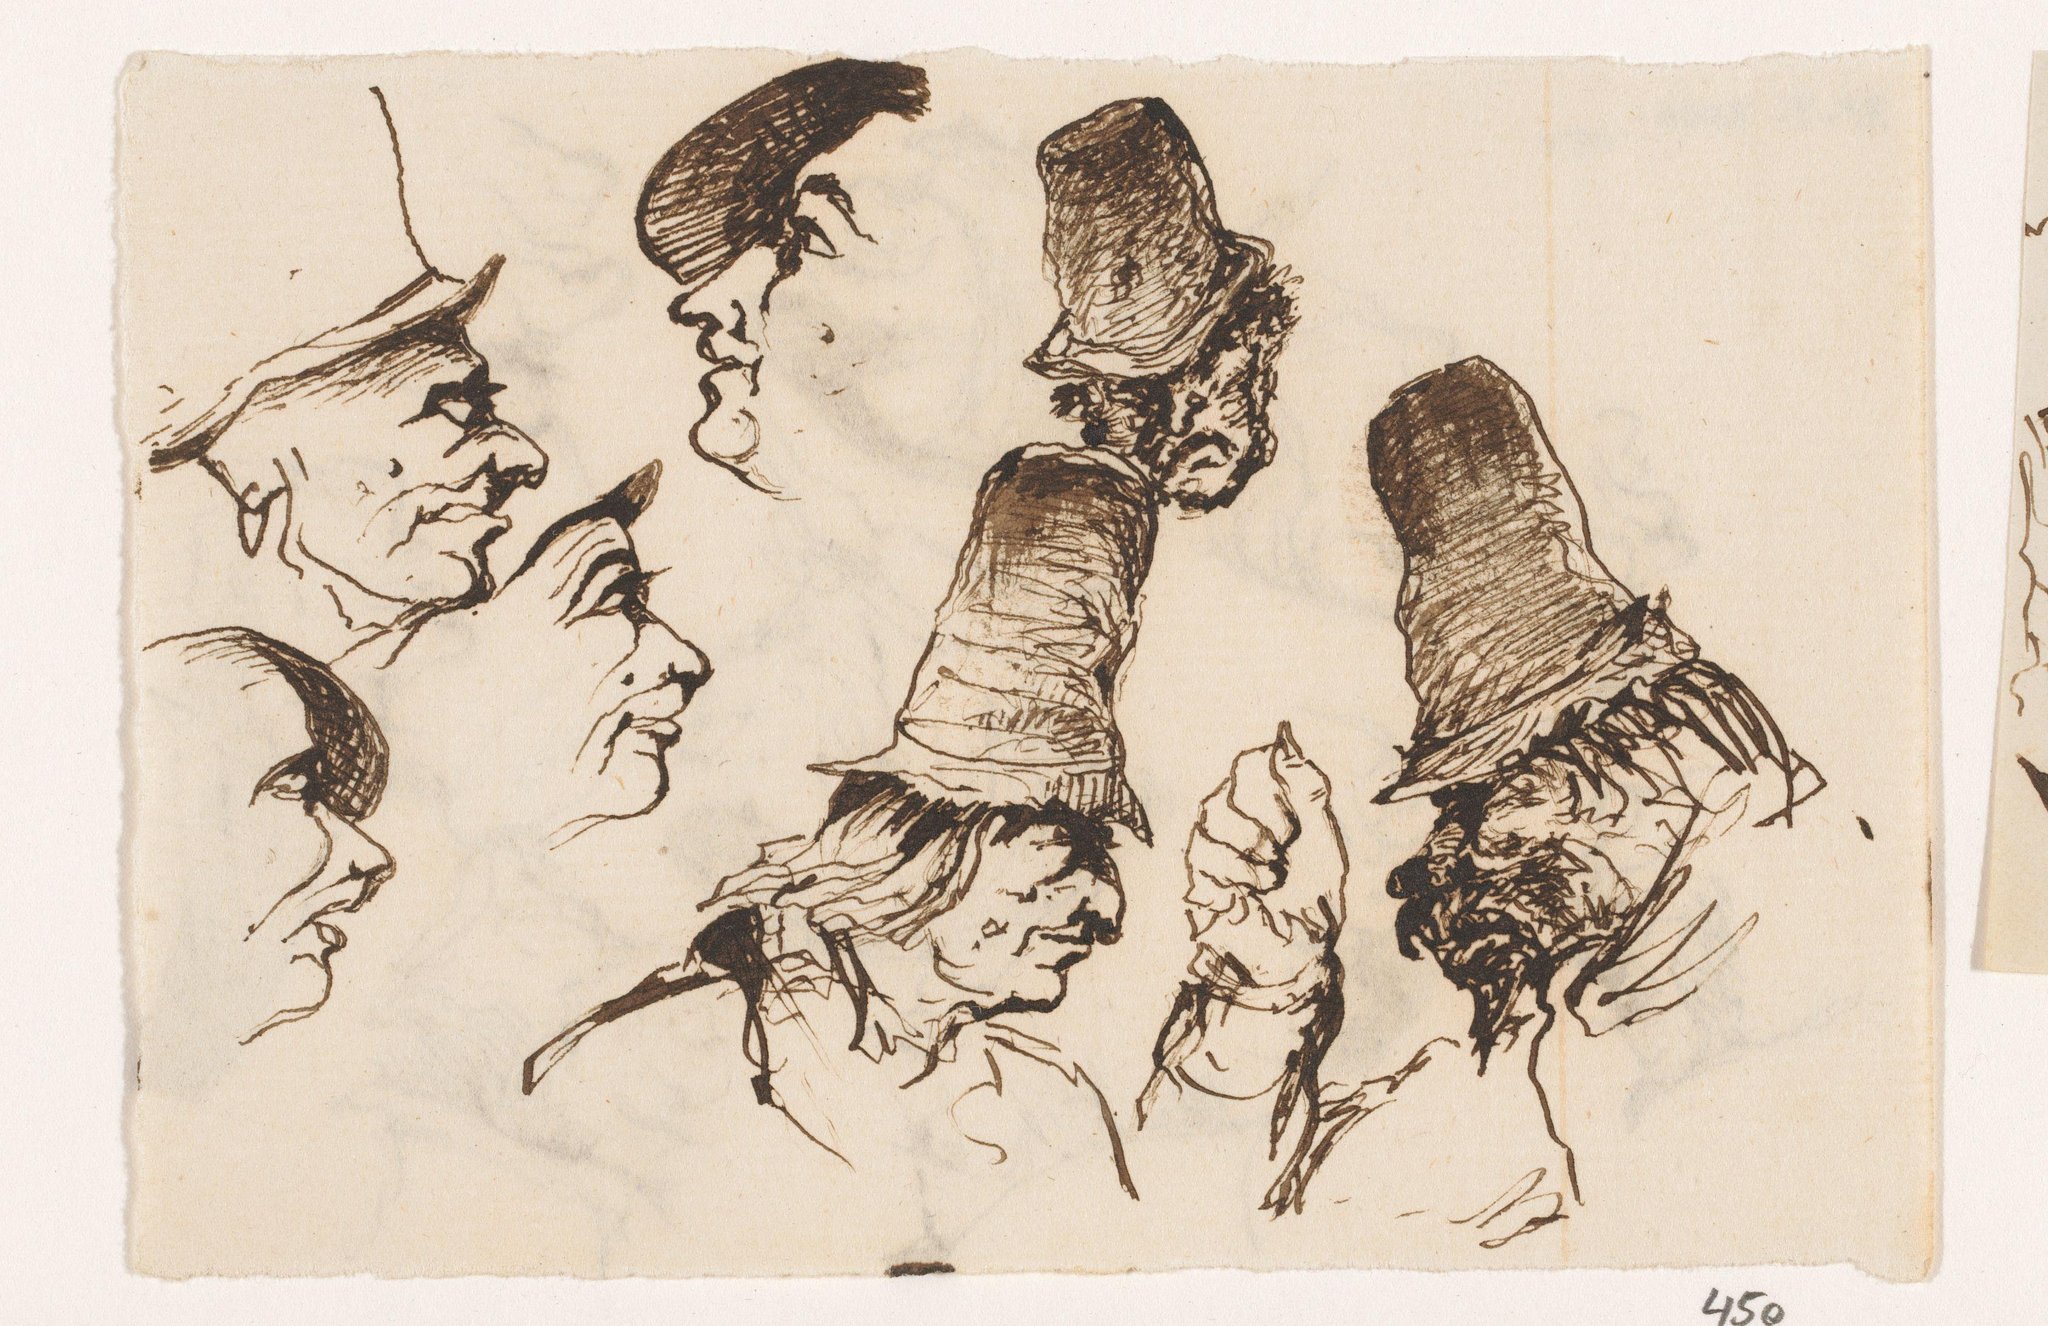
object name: drawing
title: Blad met koppen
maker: johannes tavenraat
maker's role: draughtsman, painter, print maker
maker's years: 1809-1881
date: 1840-1880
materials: ink, paper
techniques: pen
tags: caricatures (human types)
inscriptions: collector's mark: Lugt 2228